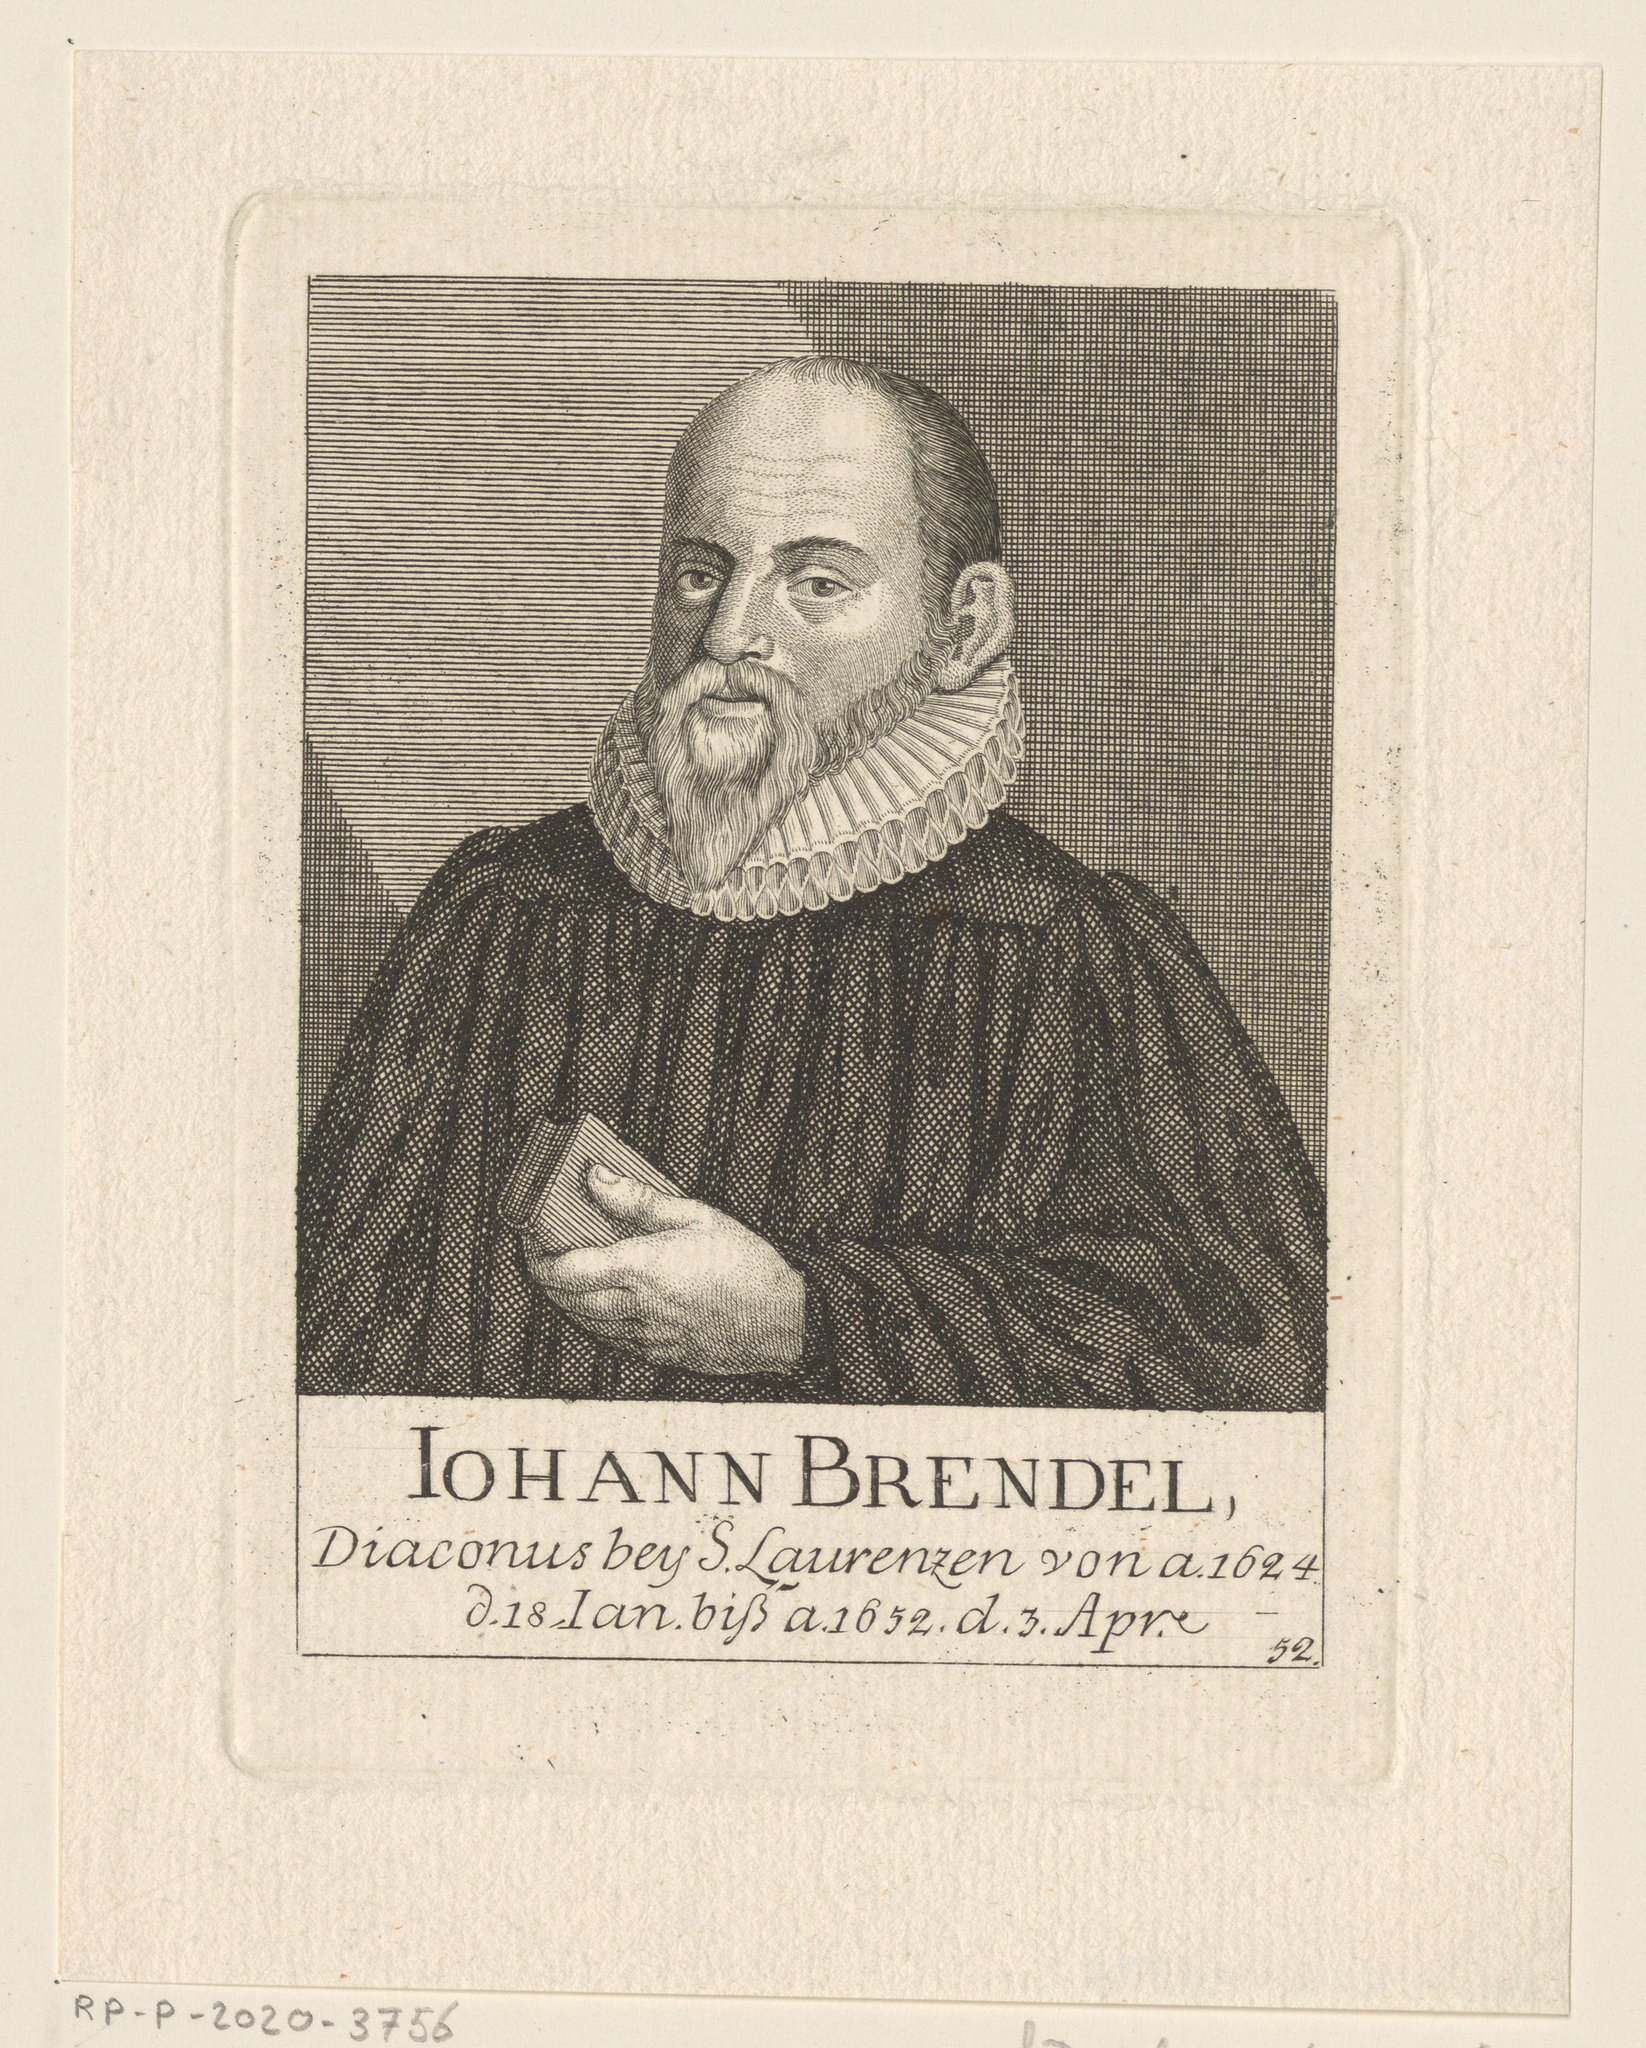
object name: book illustration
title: Portret van Johann Brendel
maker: christoph melchior roth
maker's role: print maker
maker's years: 1720-1798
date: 1756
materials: paper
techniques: engraving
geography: nuremberg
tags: theologian, historical persons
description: Prent uit: Würfel, Andreas. Diptycha ecclesiae Sebaldianae (...). Neurenberg: Christoph Melchior Roth, 1756.